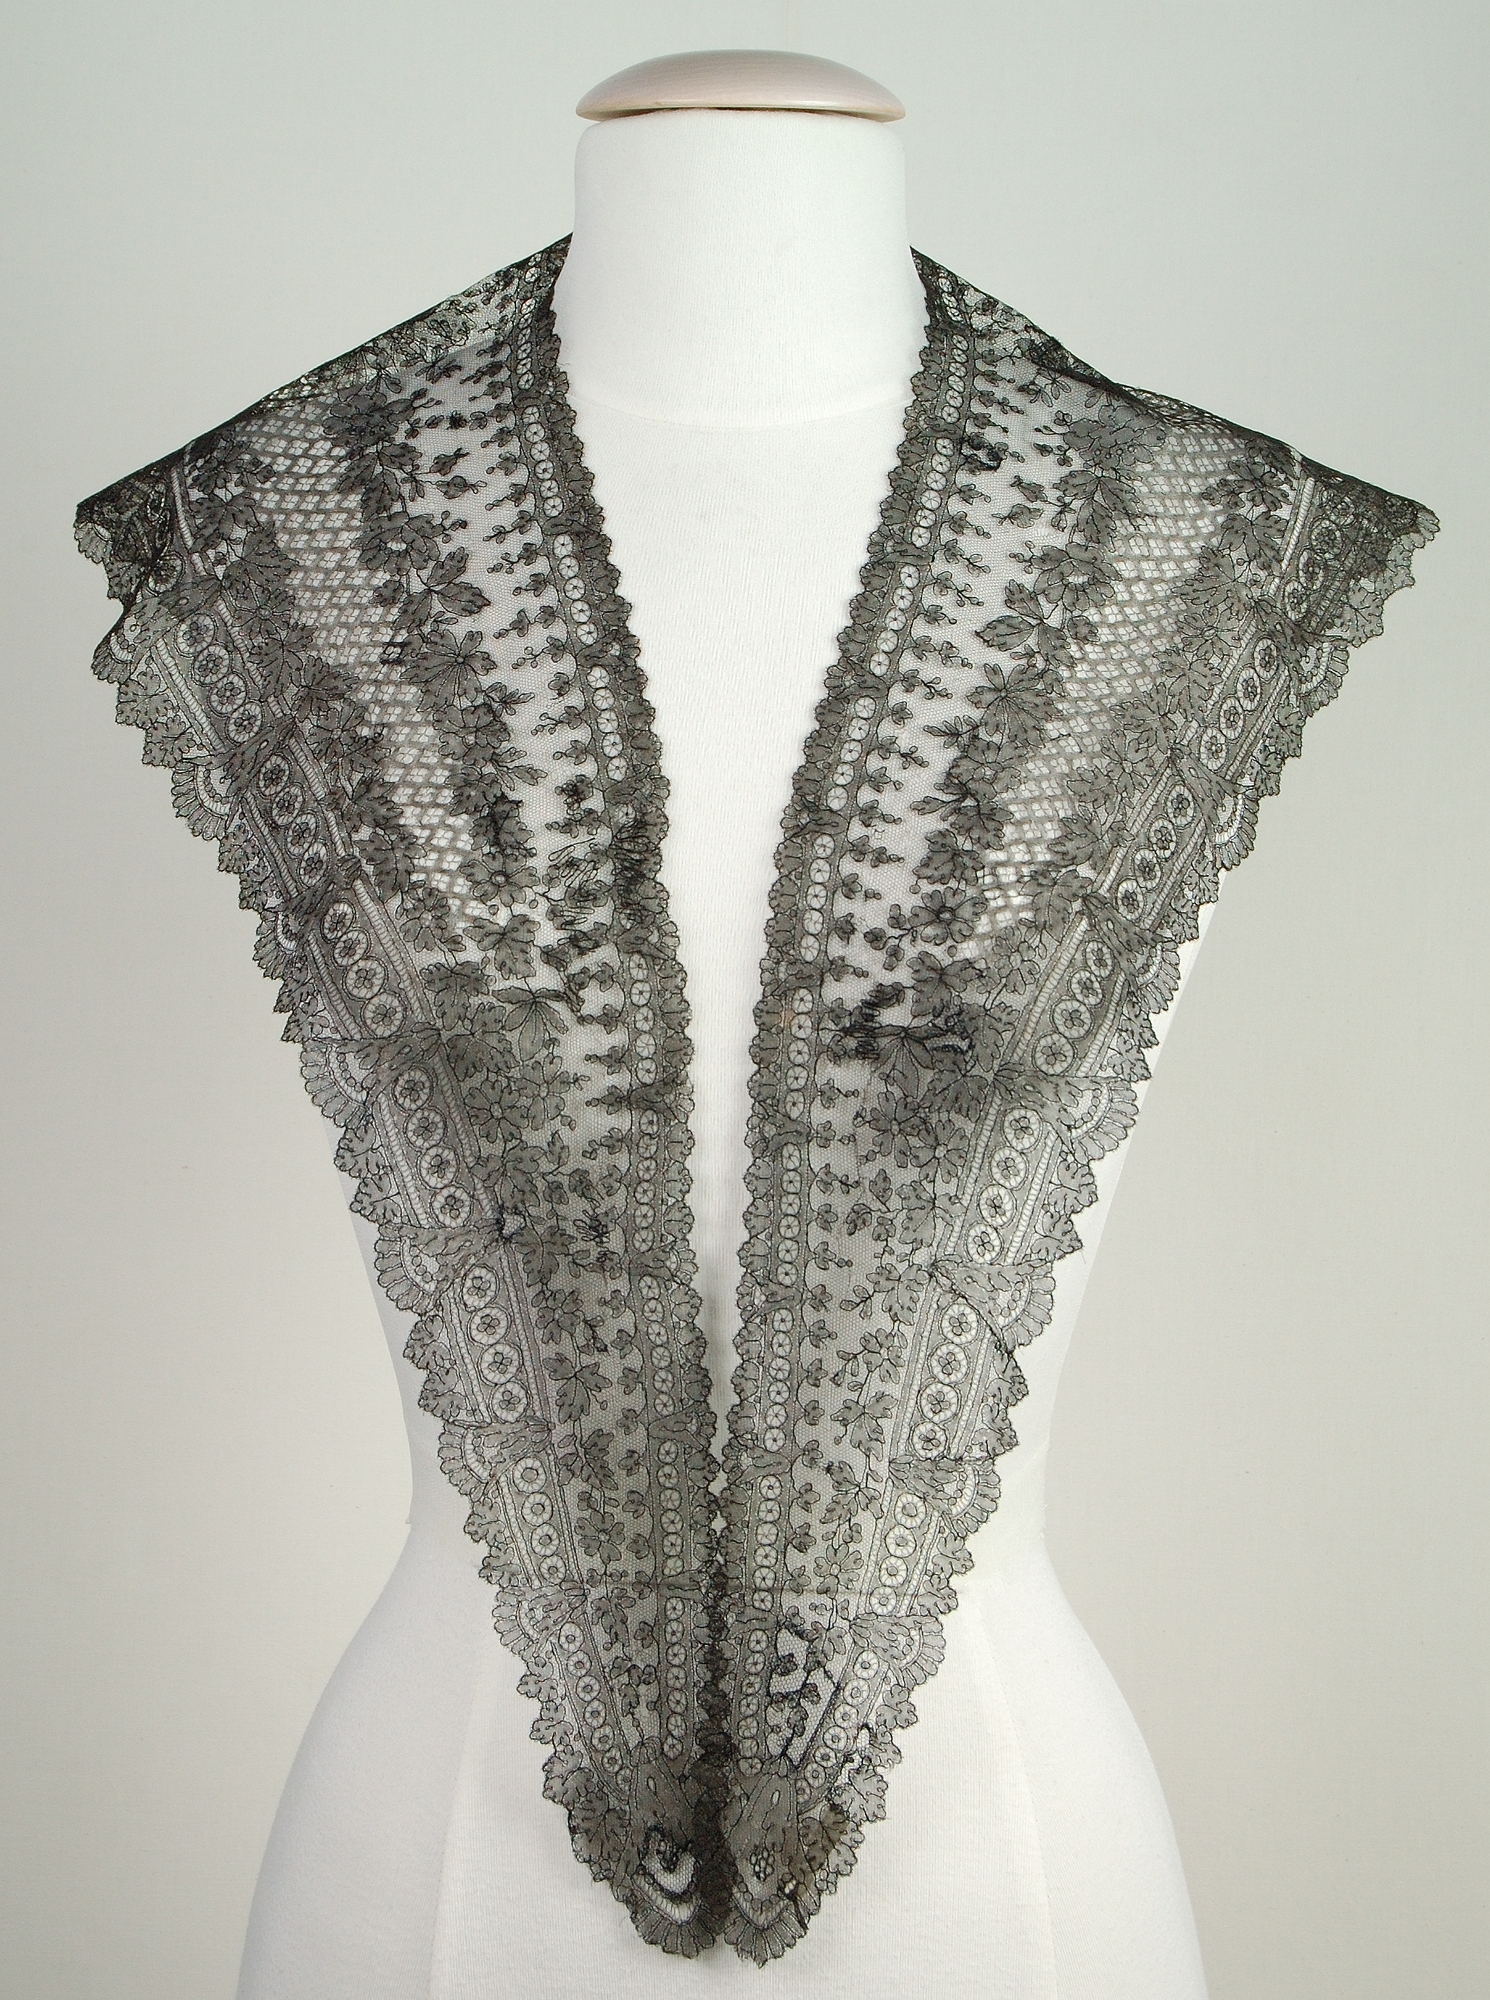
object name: fichu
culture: french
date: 1877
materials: silk